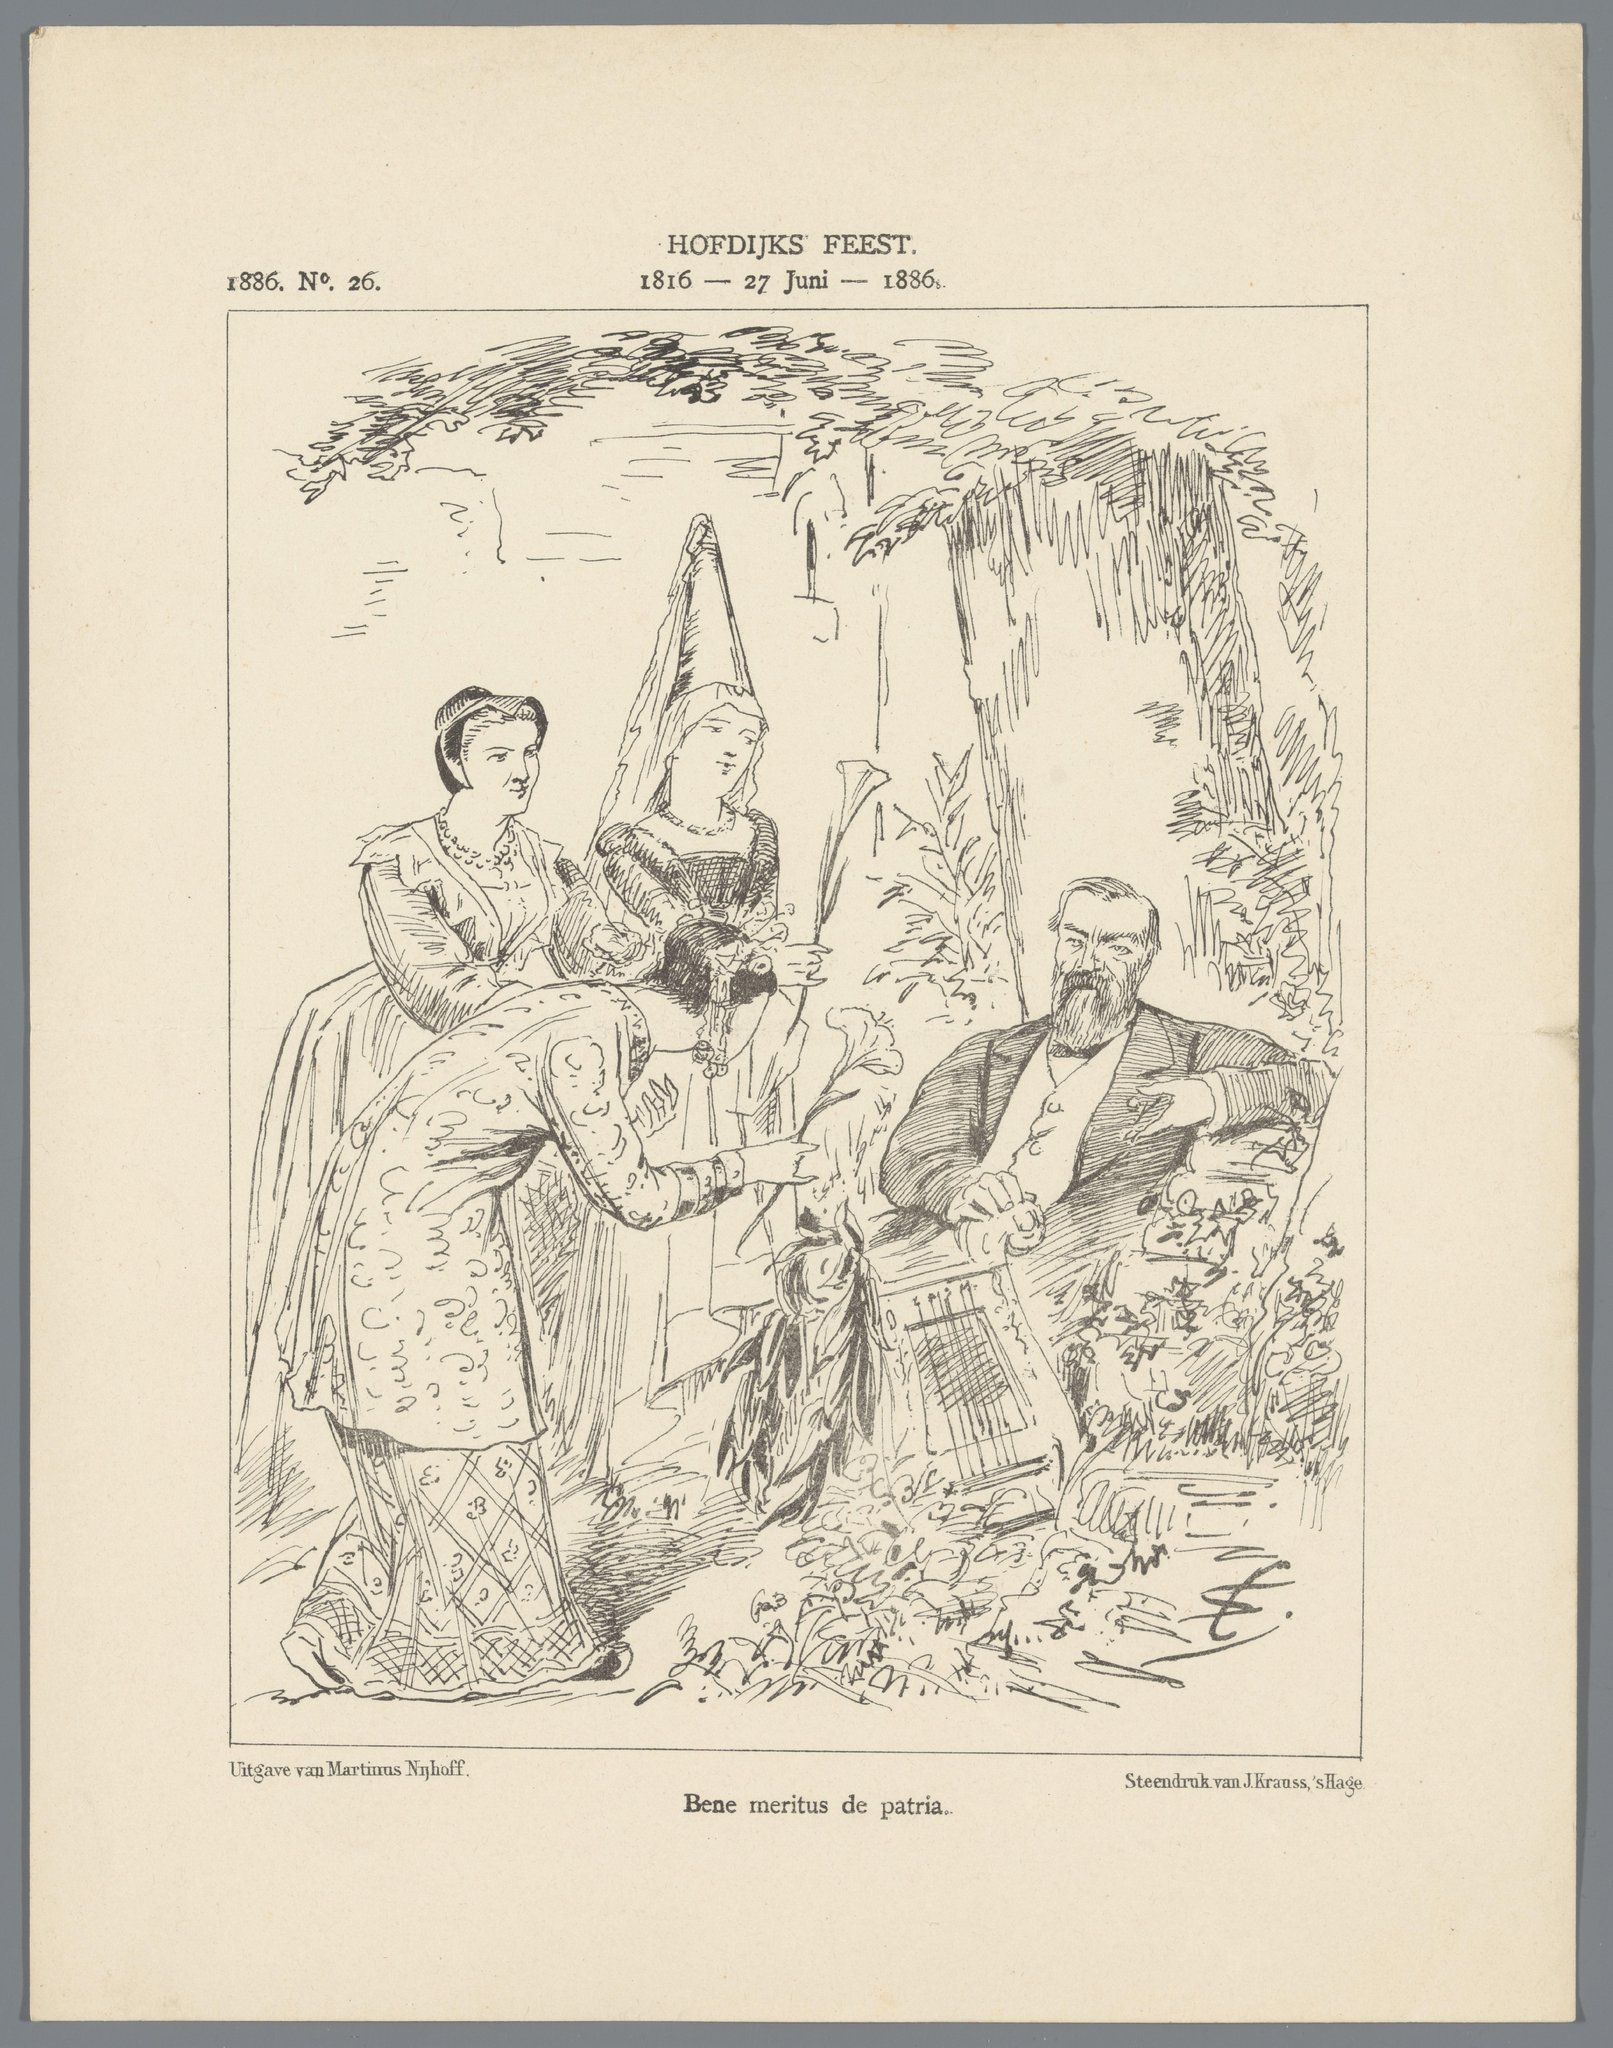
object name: print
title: Willem Hofdijks 70ste verjaardag, 1816-1886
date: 1886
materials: paper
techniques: lithograph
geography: the hague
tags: alkmaar, dichter, letterkundige, willem jacobs hofdijk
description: Bij de 70ste verjaardag van de schrijver Willem Hofdijk, 27 juni 1816-1886. Plaat verschenen bij het weekblad De Nederlandsche Spectator, nr. 26, 1886.